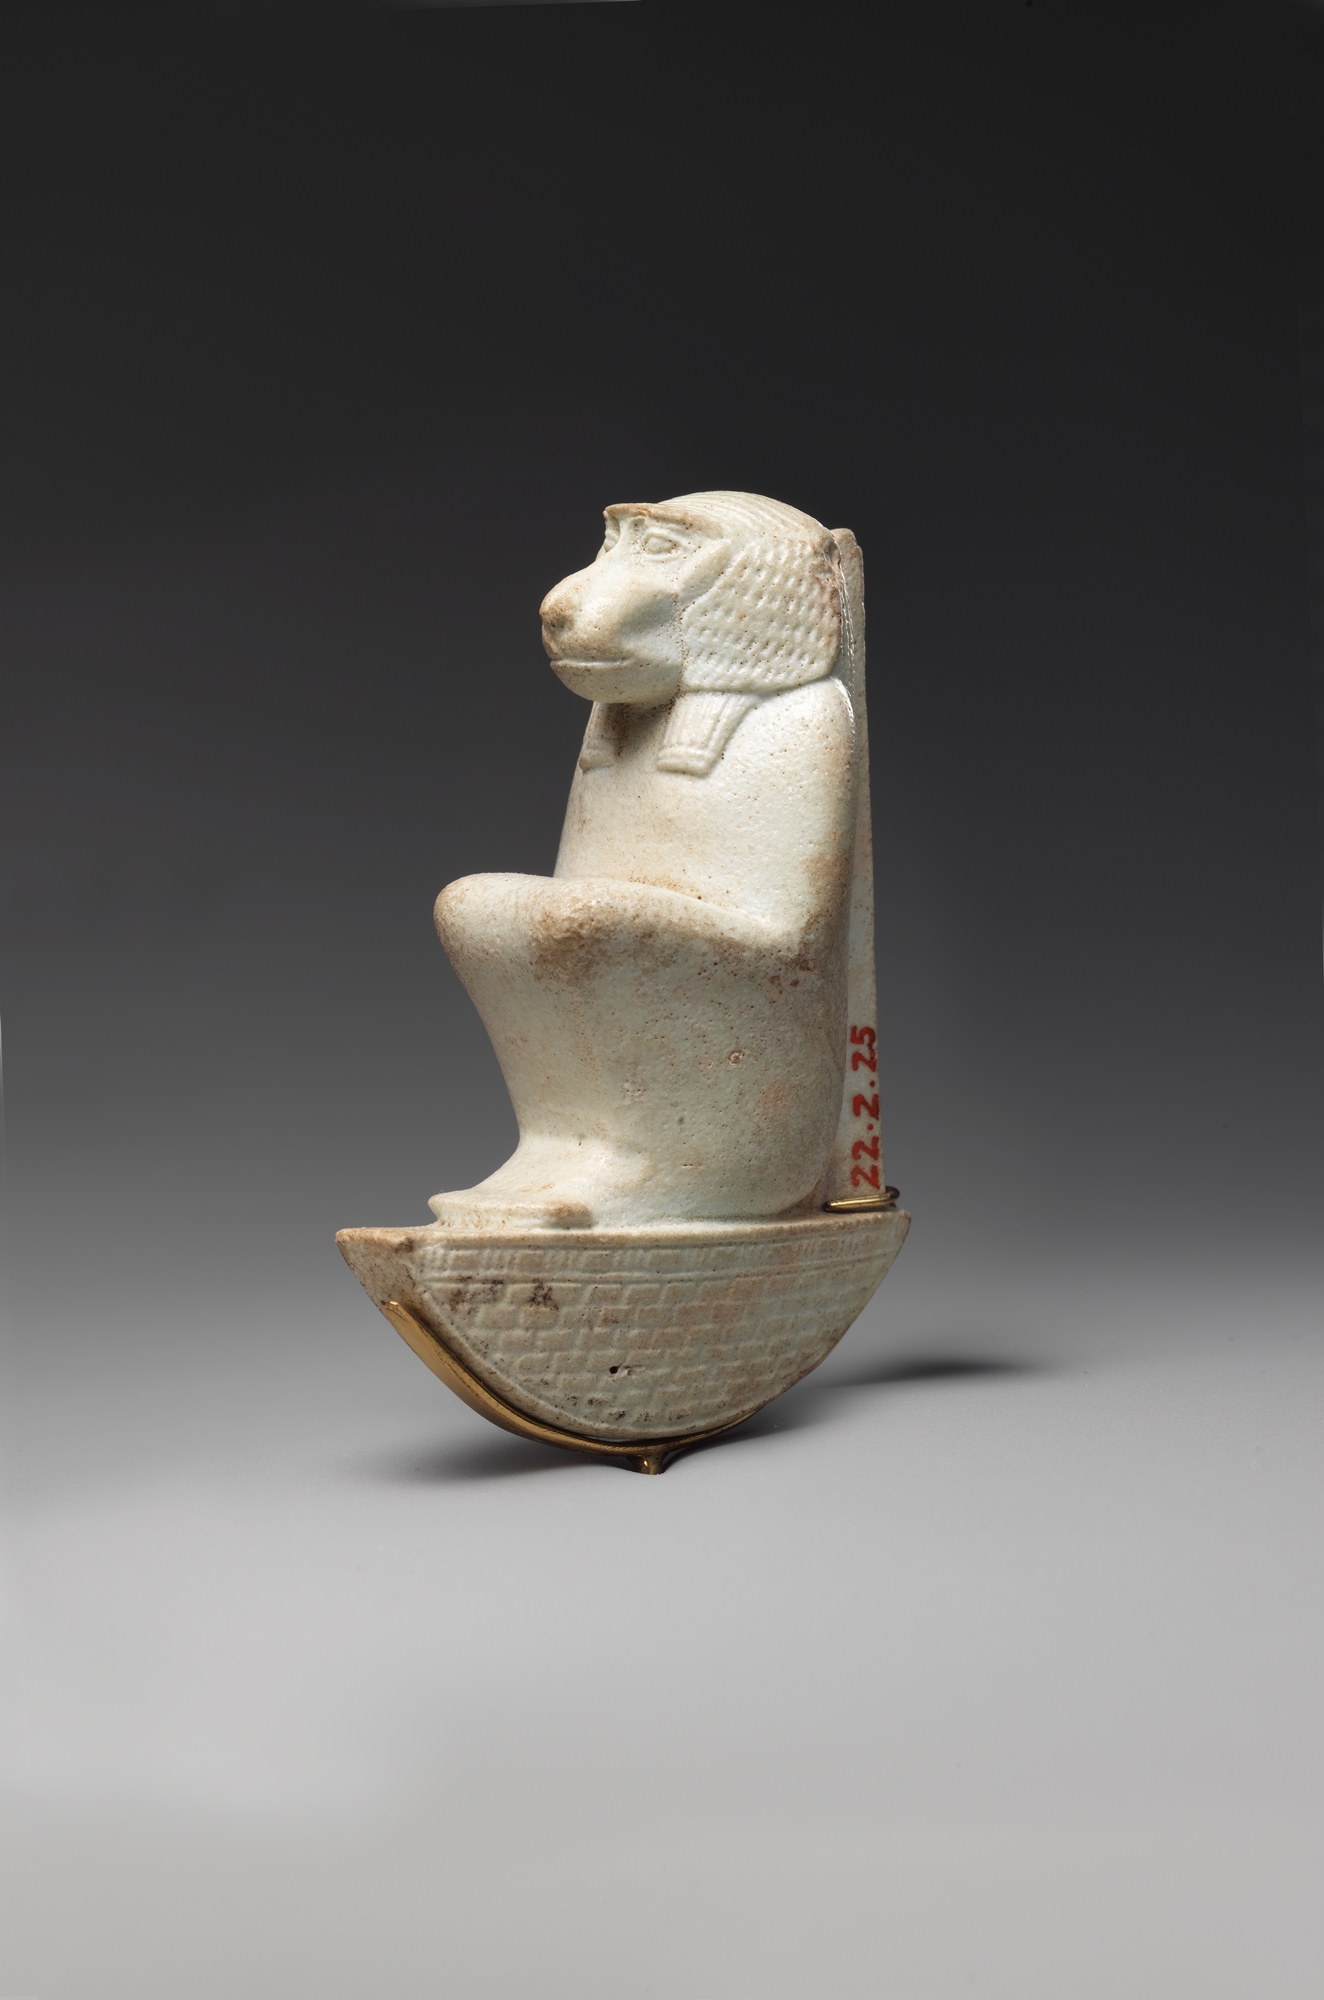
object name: amulet, baboon, basket, pillar, shebet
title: Figure of baboon on a basket and with a pillar, the shebet offering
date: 664-332 BCE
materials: faience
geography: egypt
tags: baboons